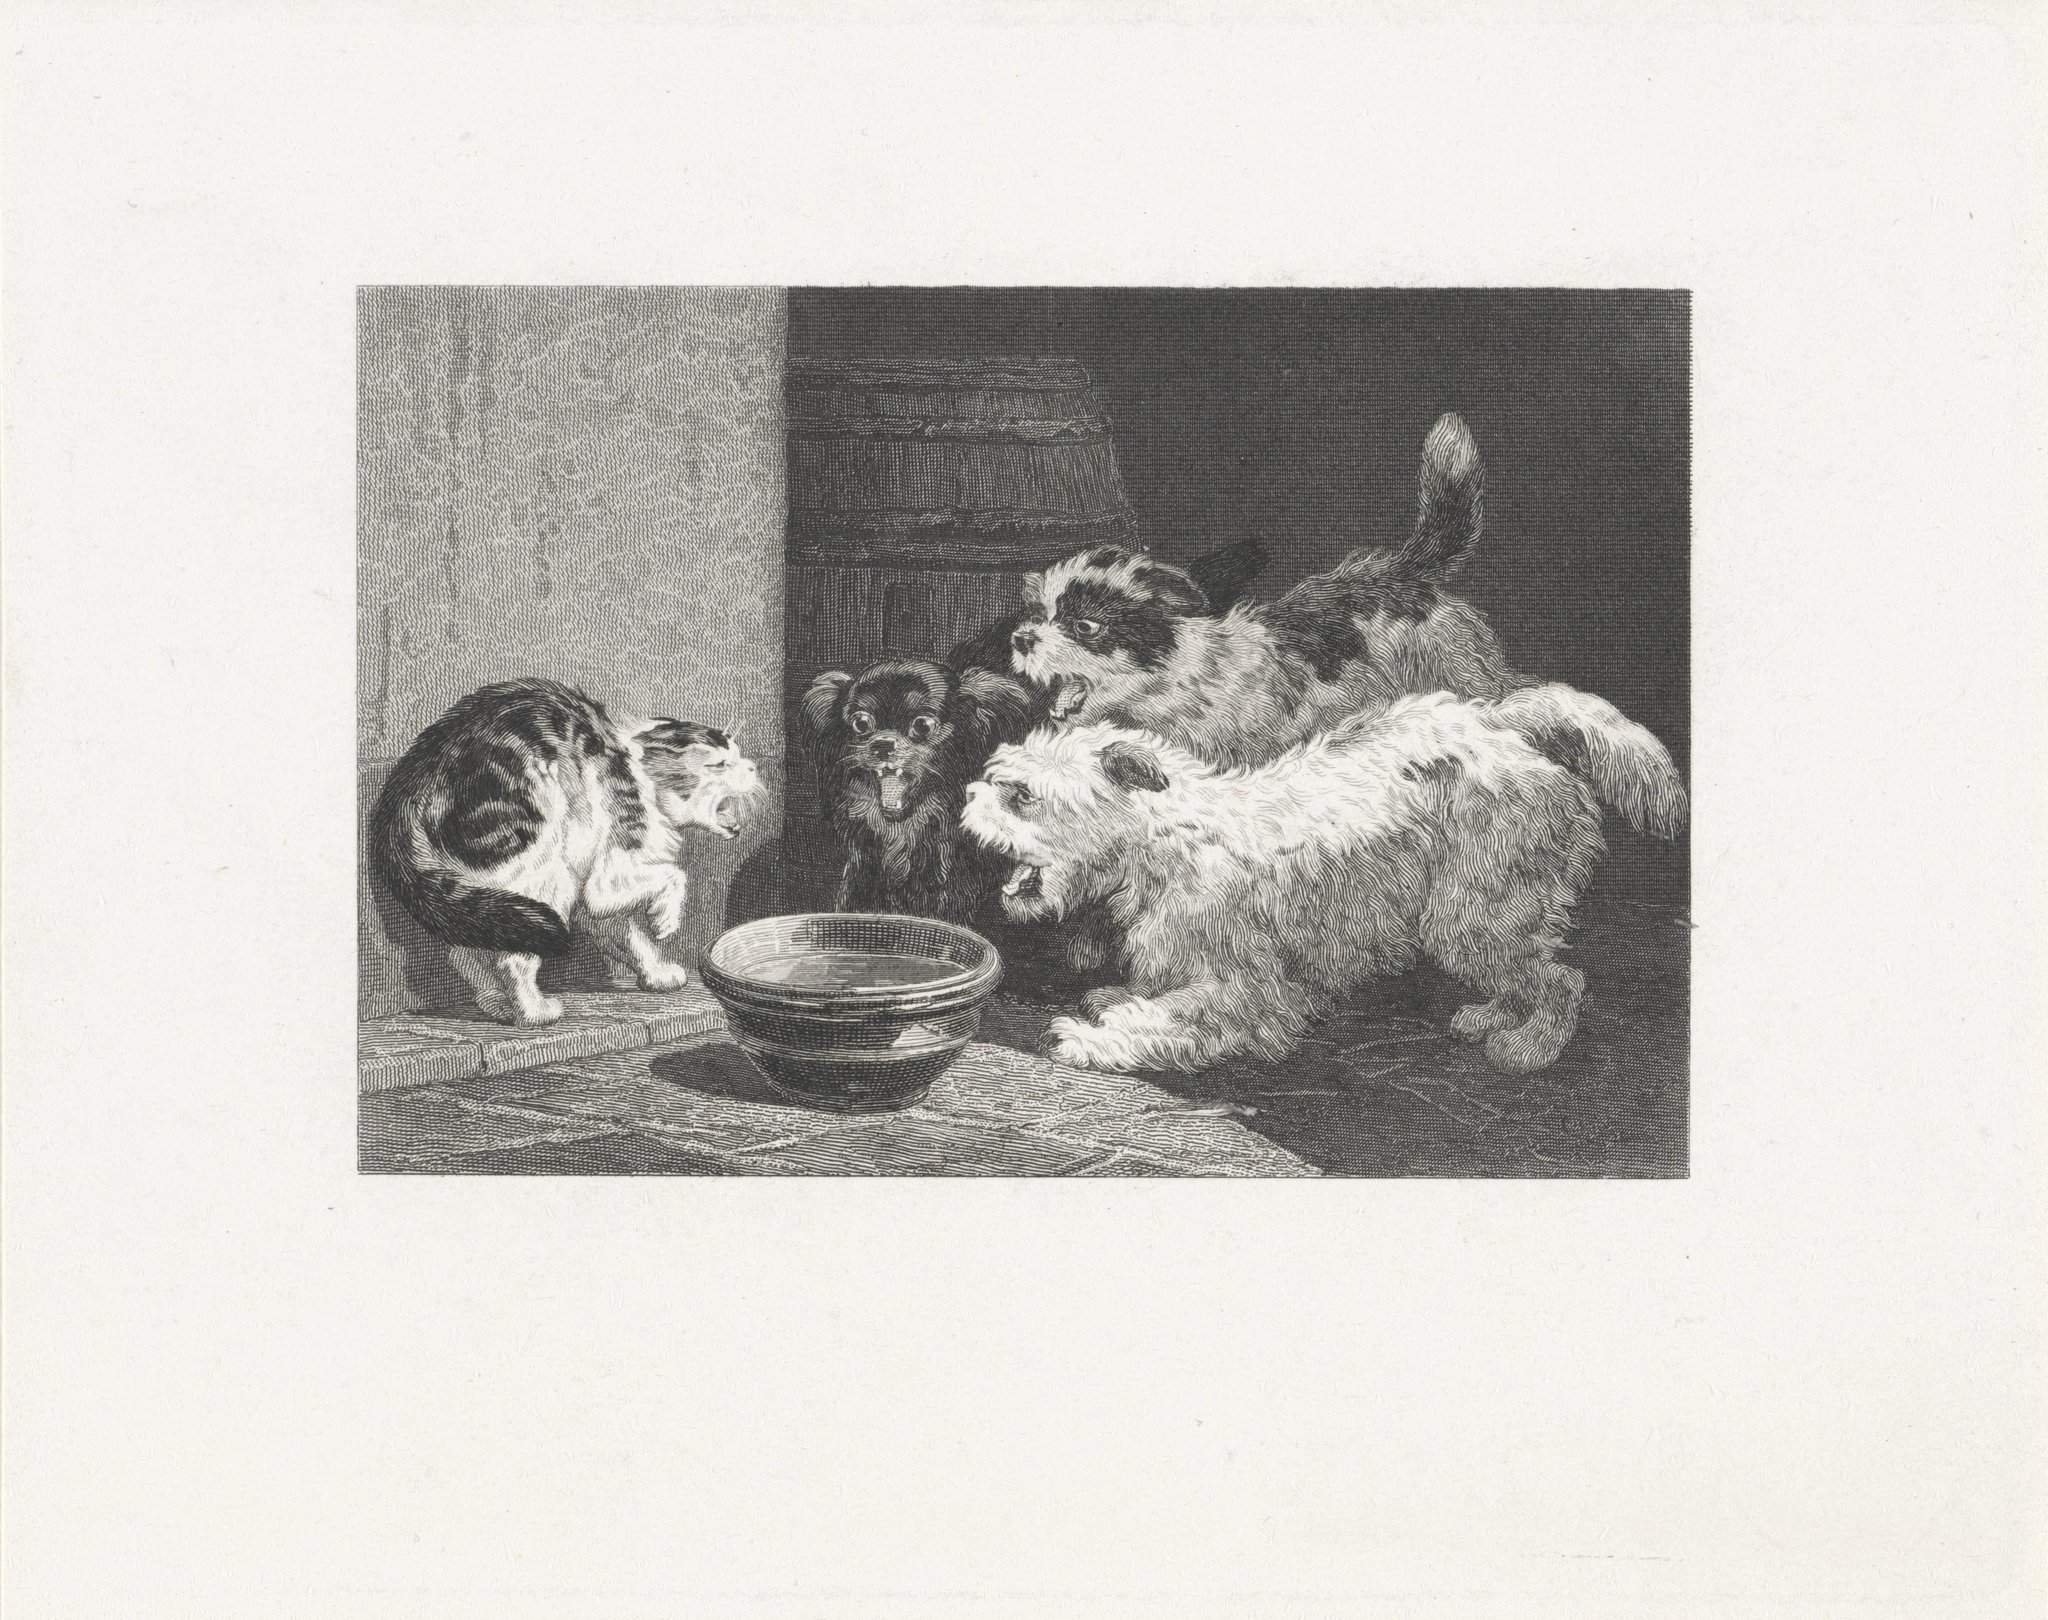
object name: print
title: Kat in het nauw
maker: dirk jurriaan sluyter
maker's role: draughtsman, print maker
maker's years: 1811-1886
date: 1826-1886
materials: paper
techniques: etching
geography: amsterdam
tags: cat, dog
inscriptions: collector's mark: Lugt 2228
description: Drie keffende hondjes drijven een blazende kat in een hoek. Tussen de dieren staat een grote kom op de grond.